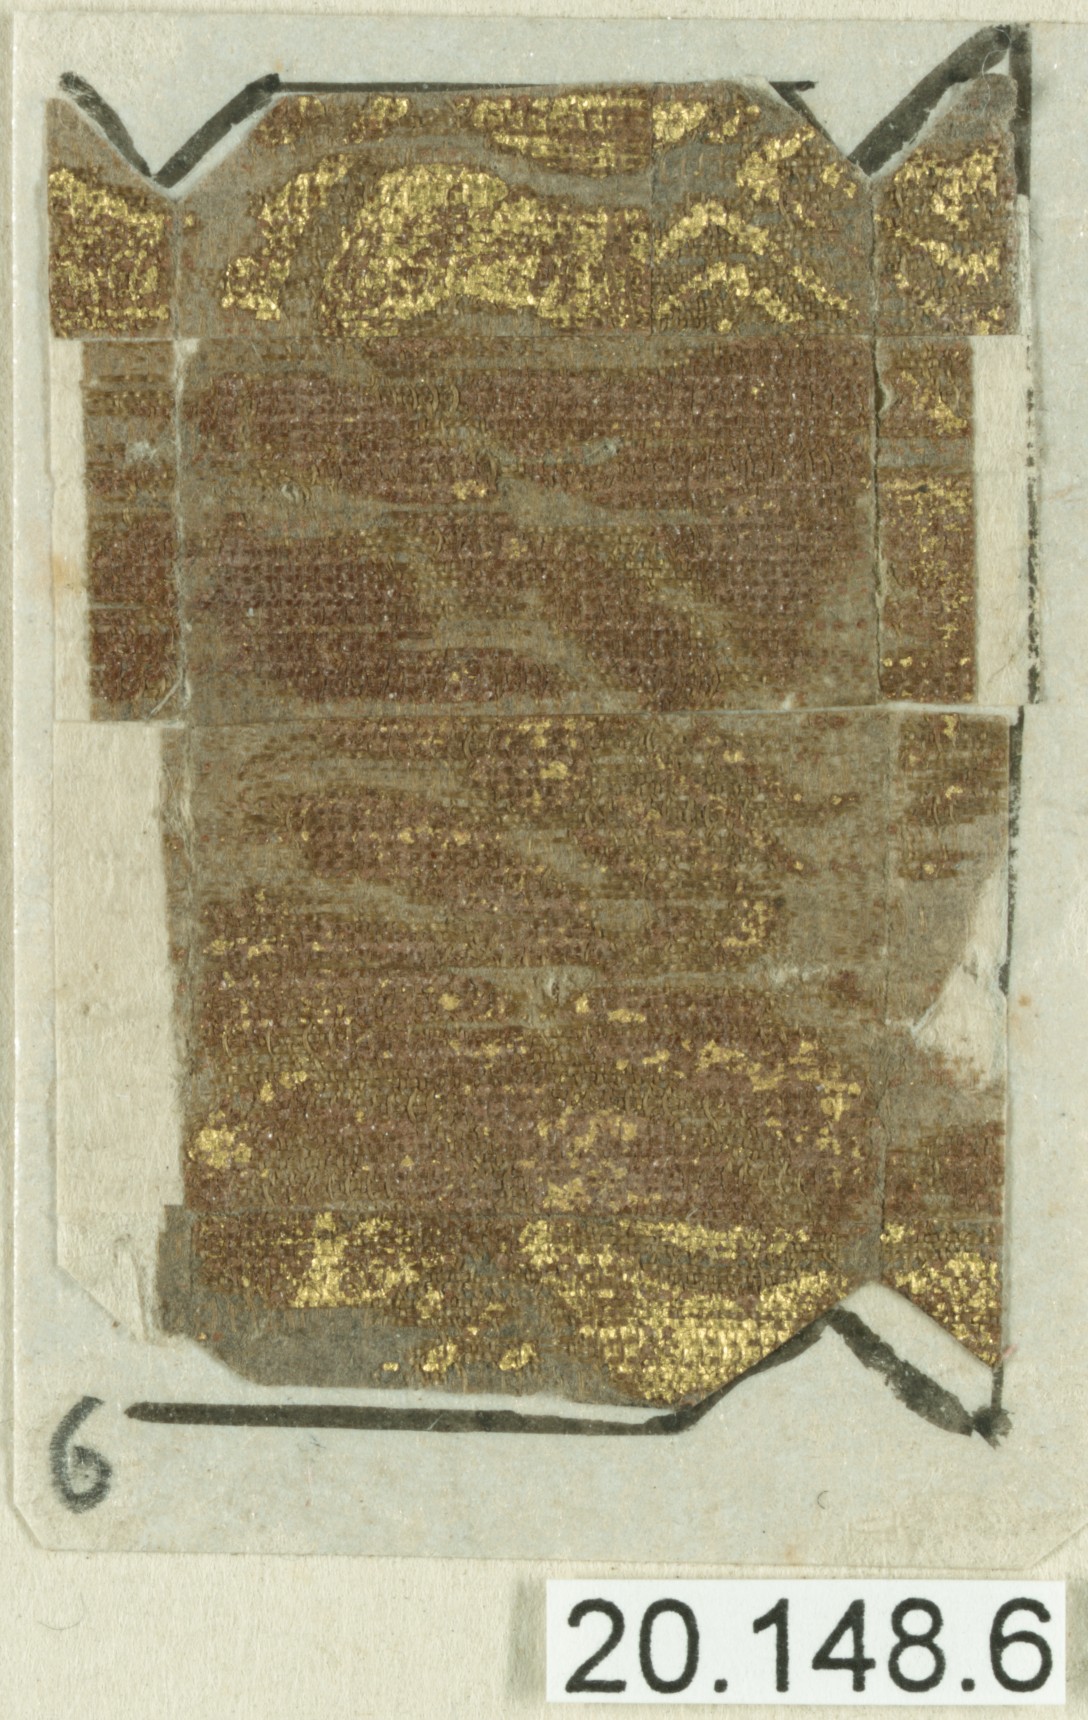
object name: piece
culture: japanese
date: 901-1000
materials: silk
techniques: compound weave